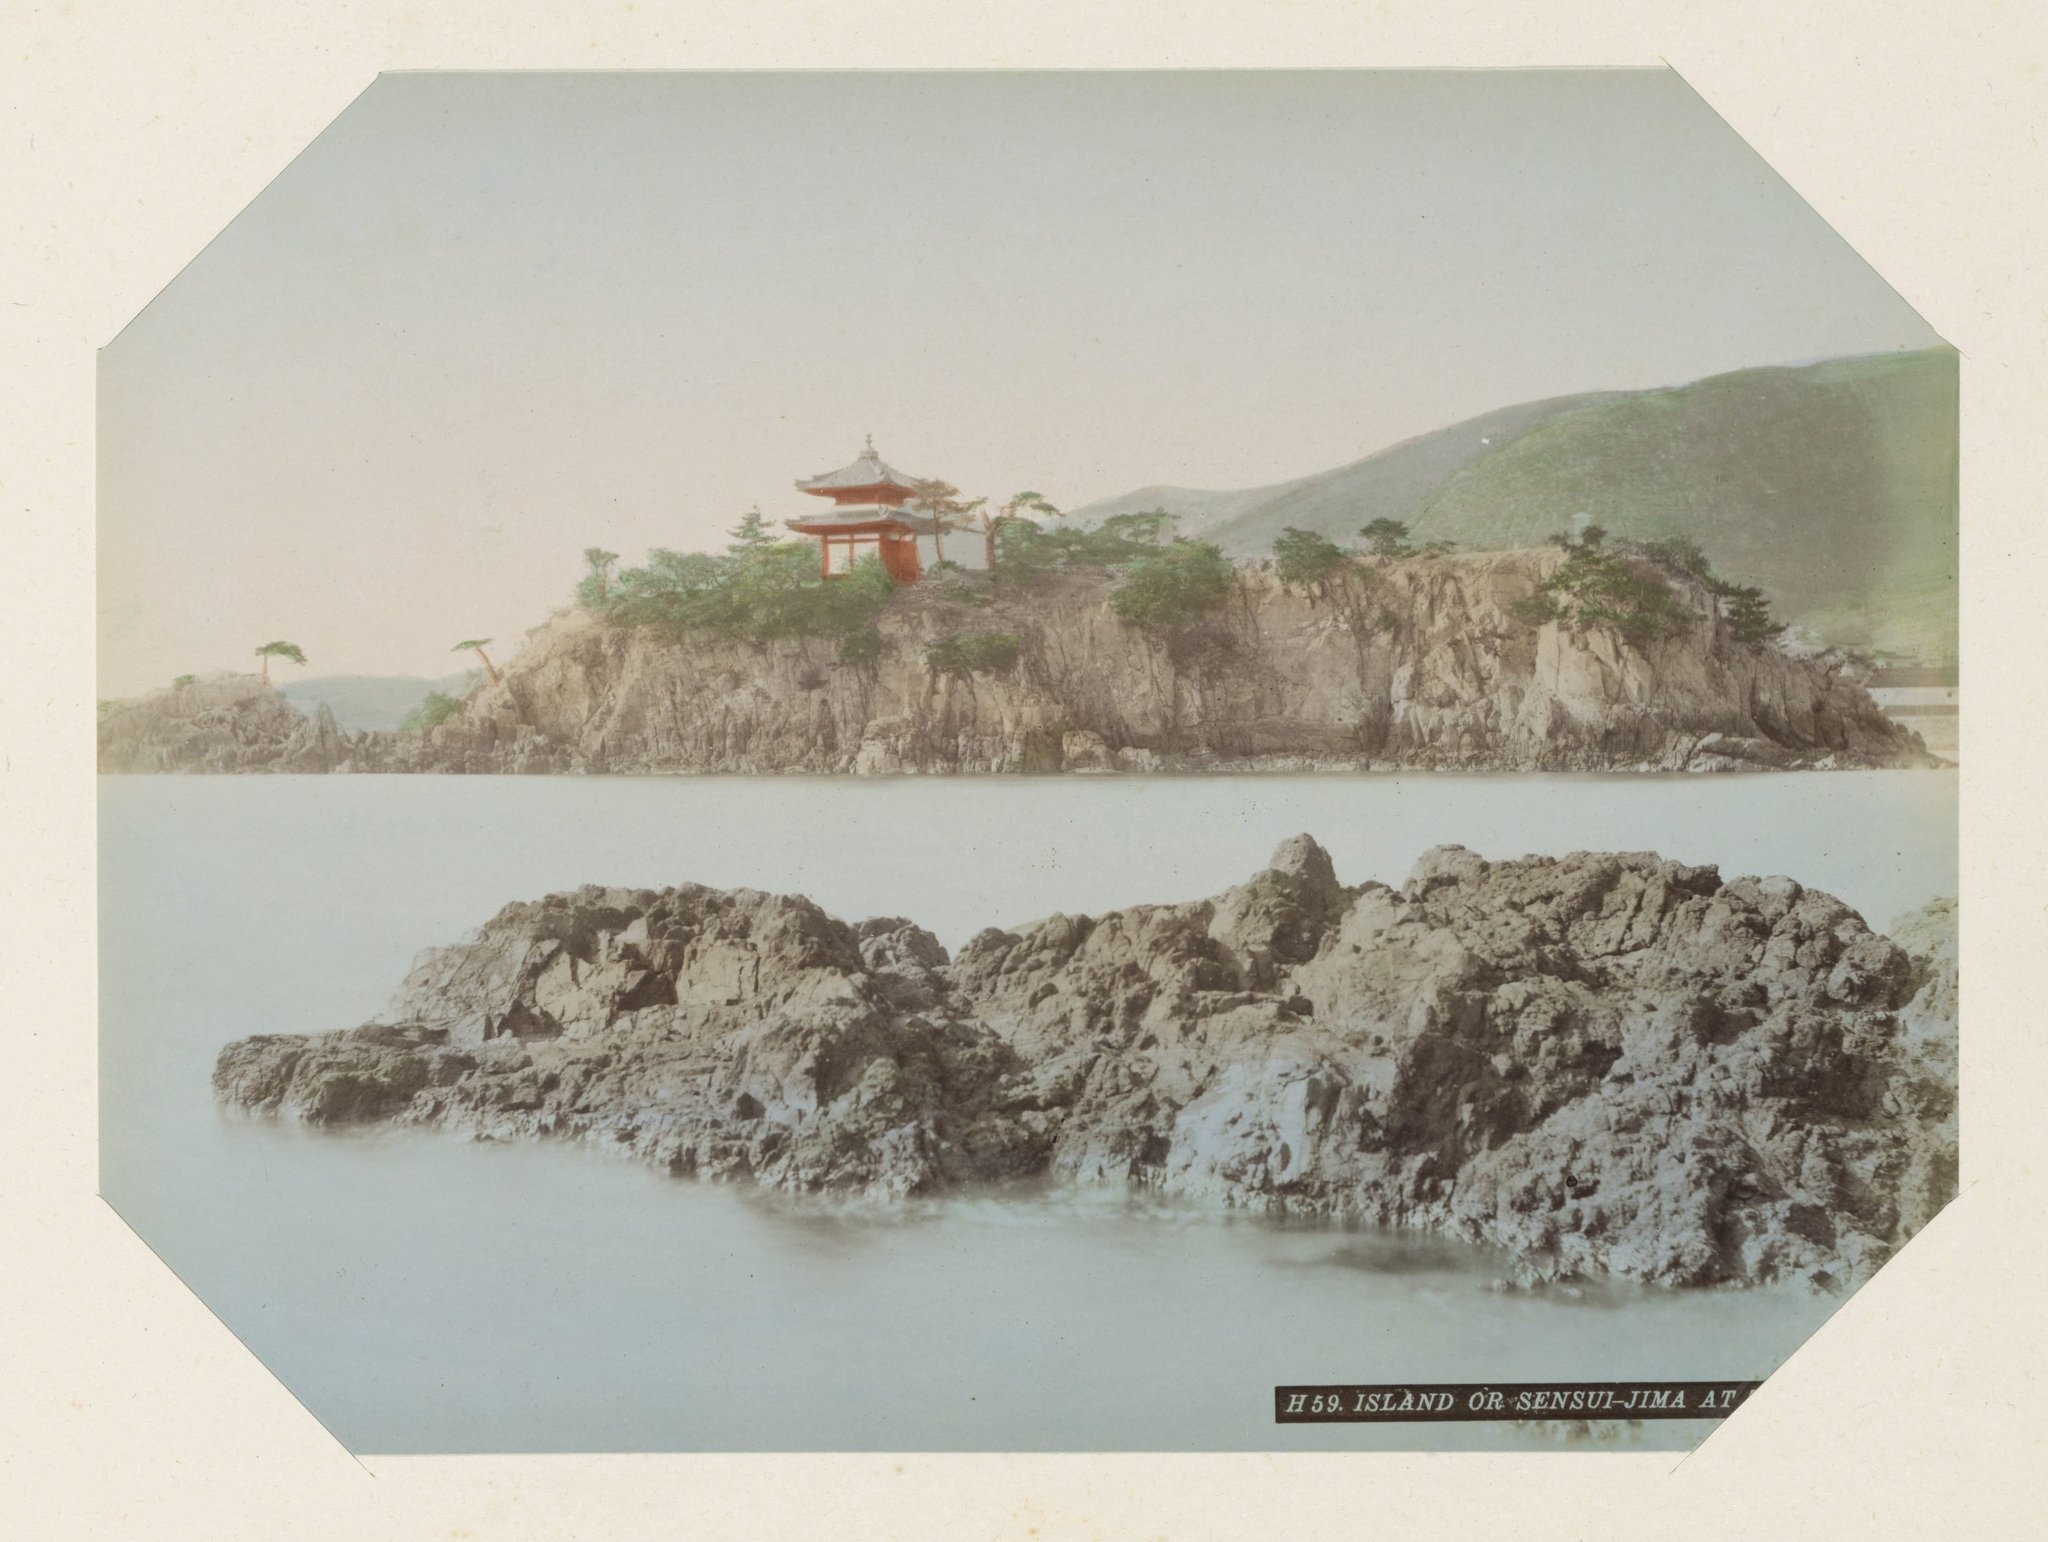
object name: photograph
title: Gezicht op Sensui-jima in Japan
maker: Anonymous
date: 1870-1900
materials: paint, photographic support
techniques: albumen print, hand coloring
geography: sensui-jima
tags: island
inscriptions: number: ‘H 59’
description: Onderdeel van Fotoalbum met opnames van bezienswaardigheden in Japan en studioportretten.